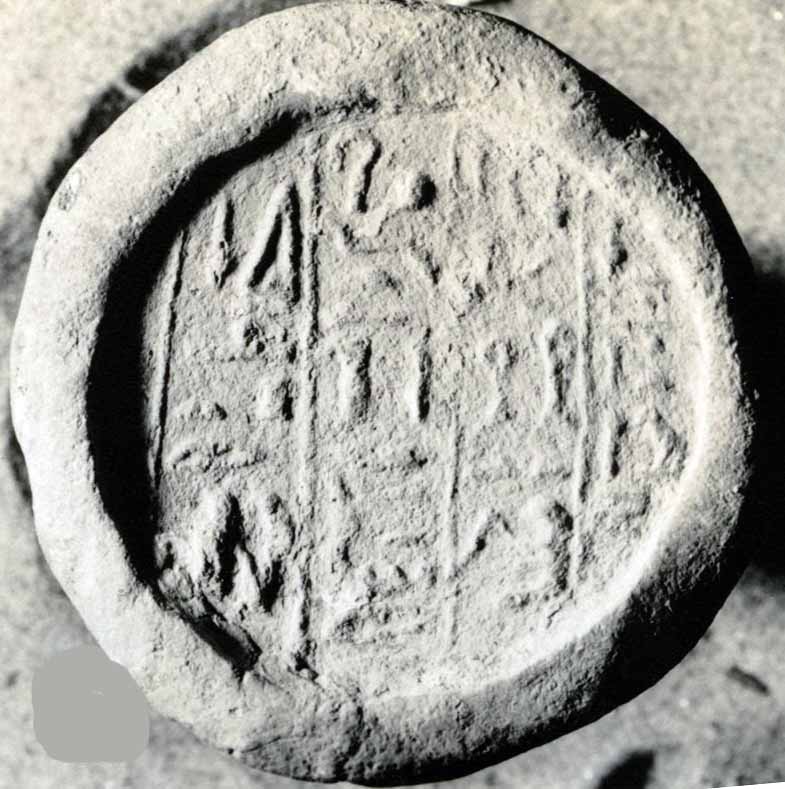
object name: cone, pawah, circular impression, scribe, henutwadju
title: Funerary Cone of the Scribe Pawah and His Wife, Henutwadju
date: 1550-1295 BCE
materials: pottery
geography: egypt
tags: hieroglyphs